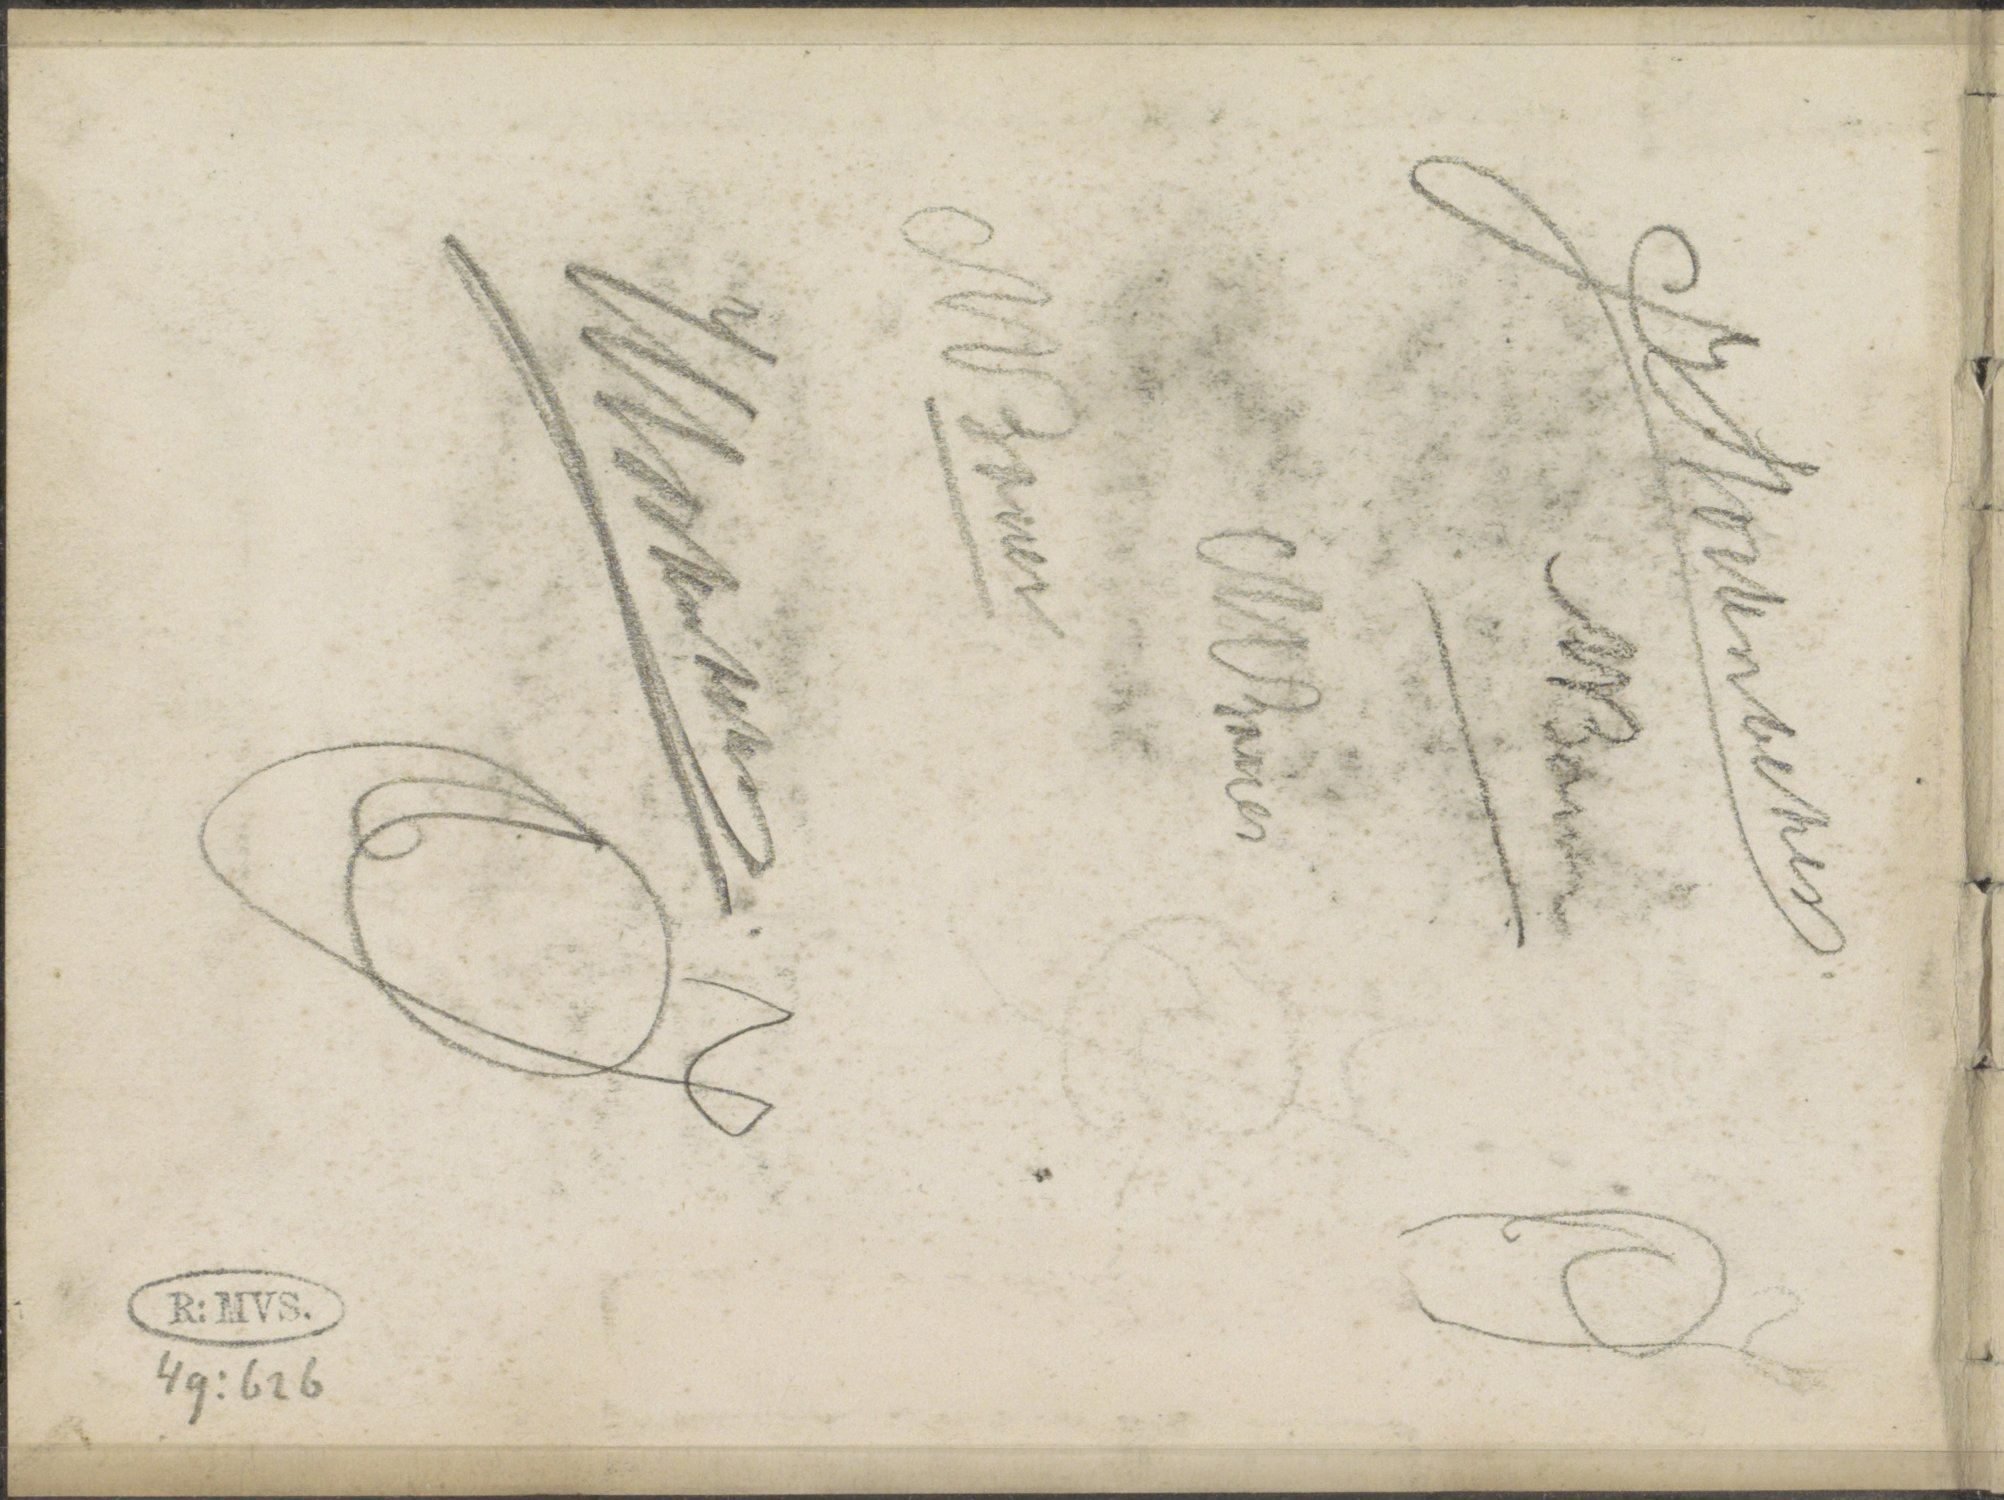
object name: sketchbook leaf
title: Blad met handtekeningen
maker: marius bauer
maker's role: draughtsman, print maker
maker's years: 1867-1932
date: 1879-1884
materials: chalk, paper, pencil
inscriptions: annotation: ‘JStortenbeker/ MBauer/ J/ MBauer/ MBauer/ [...]Stortenbeker/ J’, collector's mark: Lugt 2228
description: Voorste schutblad uit een schetsboek met 28 bladen.